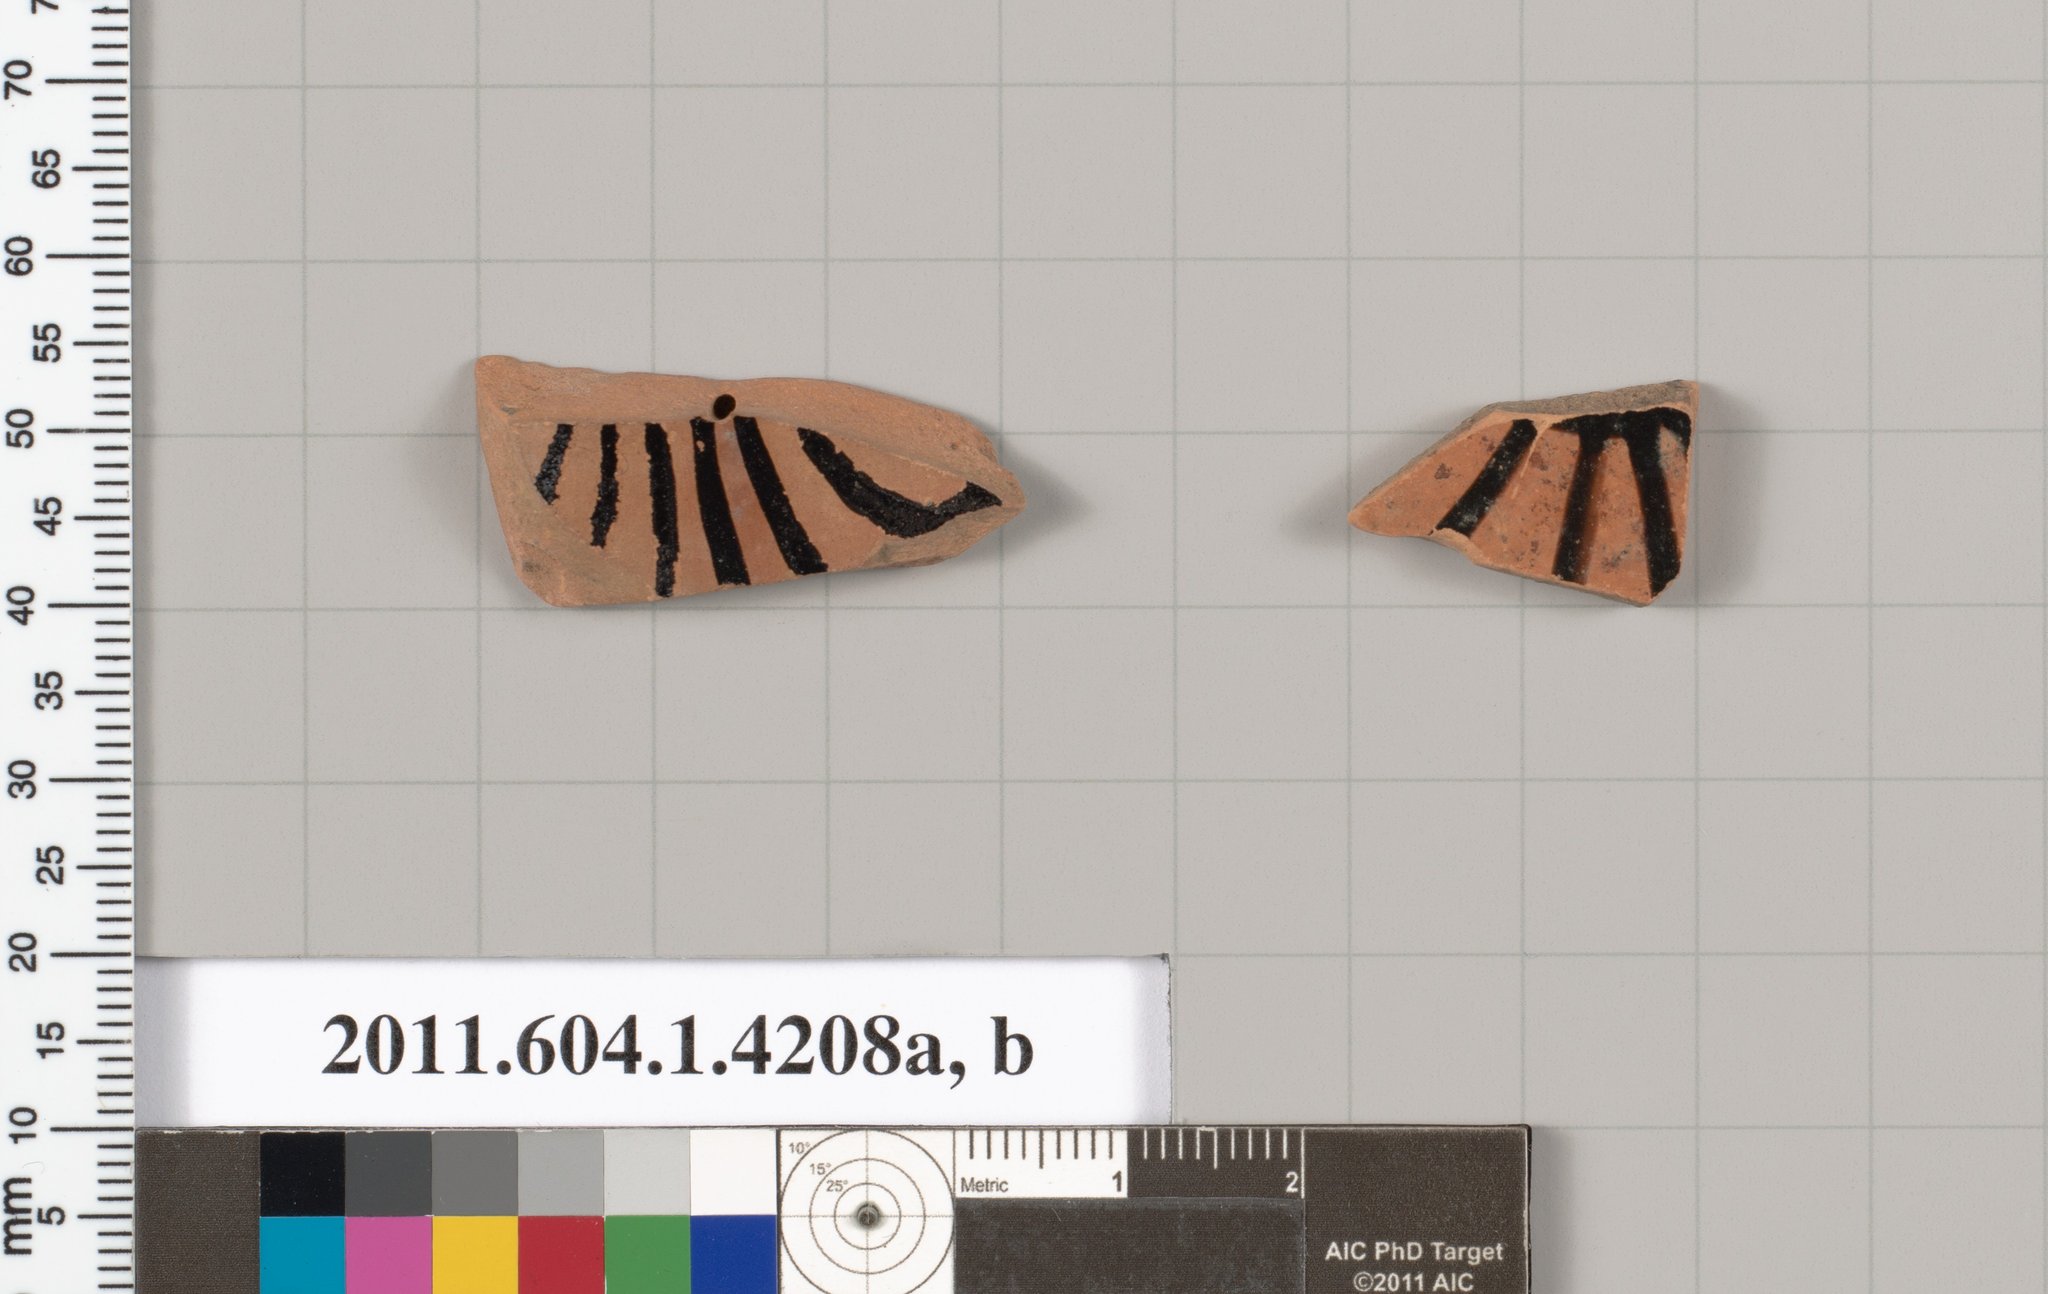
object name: kylix fragment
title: Terracotta fragments of kylikes (drinking cups)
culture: greek, attic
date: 475-451 BCE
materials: terracotta